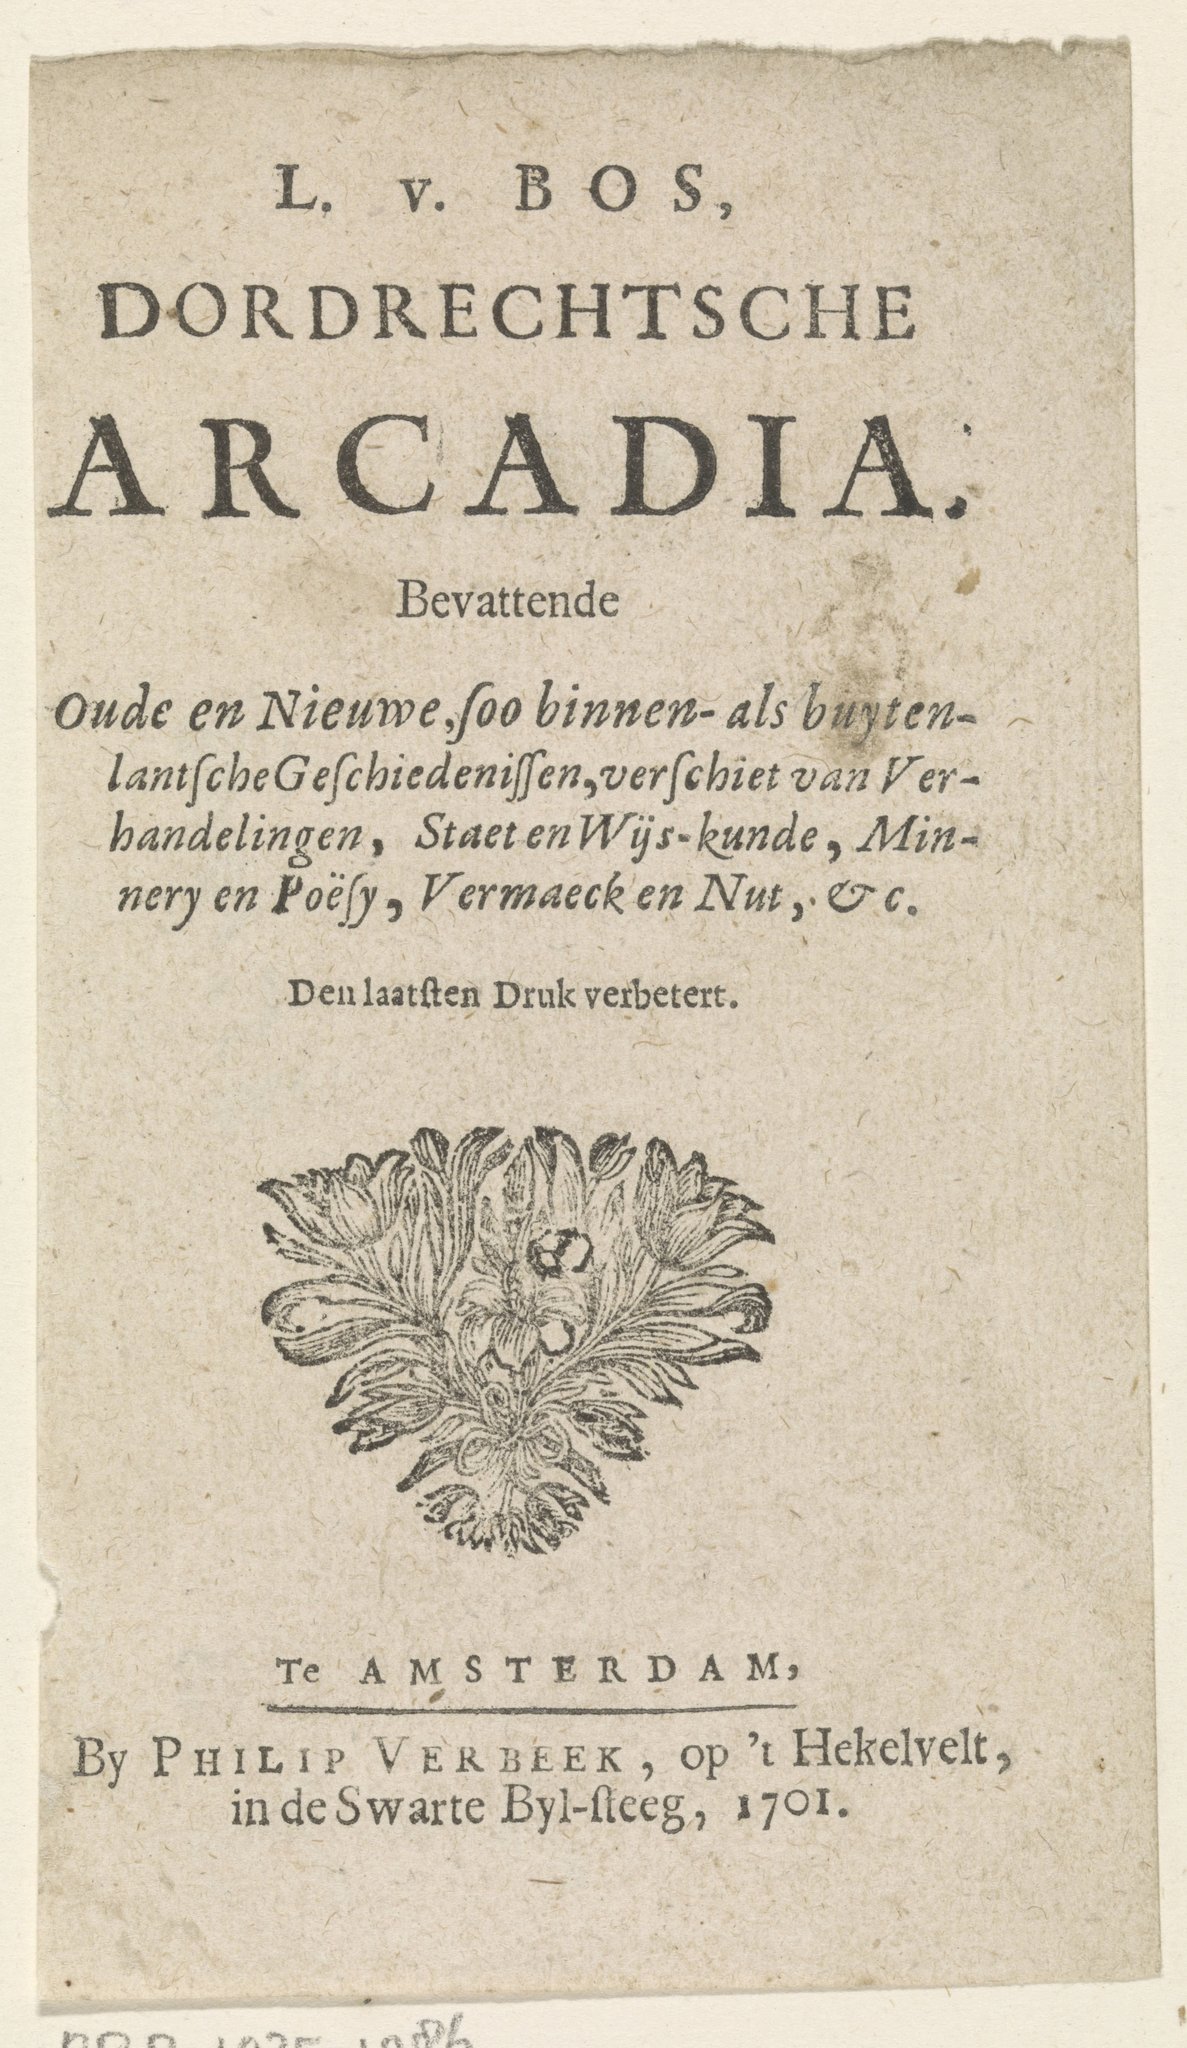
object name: text sheet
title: Titelpagina voor: Dordrechtsche Arcadia, 1701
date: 1701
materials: paper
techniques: letterpress printing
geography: middelburg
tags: flowers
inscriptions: collector's mark: Lugt 2760, collector's mark: Lugt 2228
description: Titelpagina voor: Bos, Lambert van den, Dordrechtsche Arcadia. Amsterdam: Philip Verbeek, 1701.